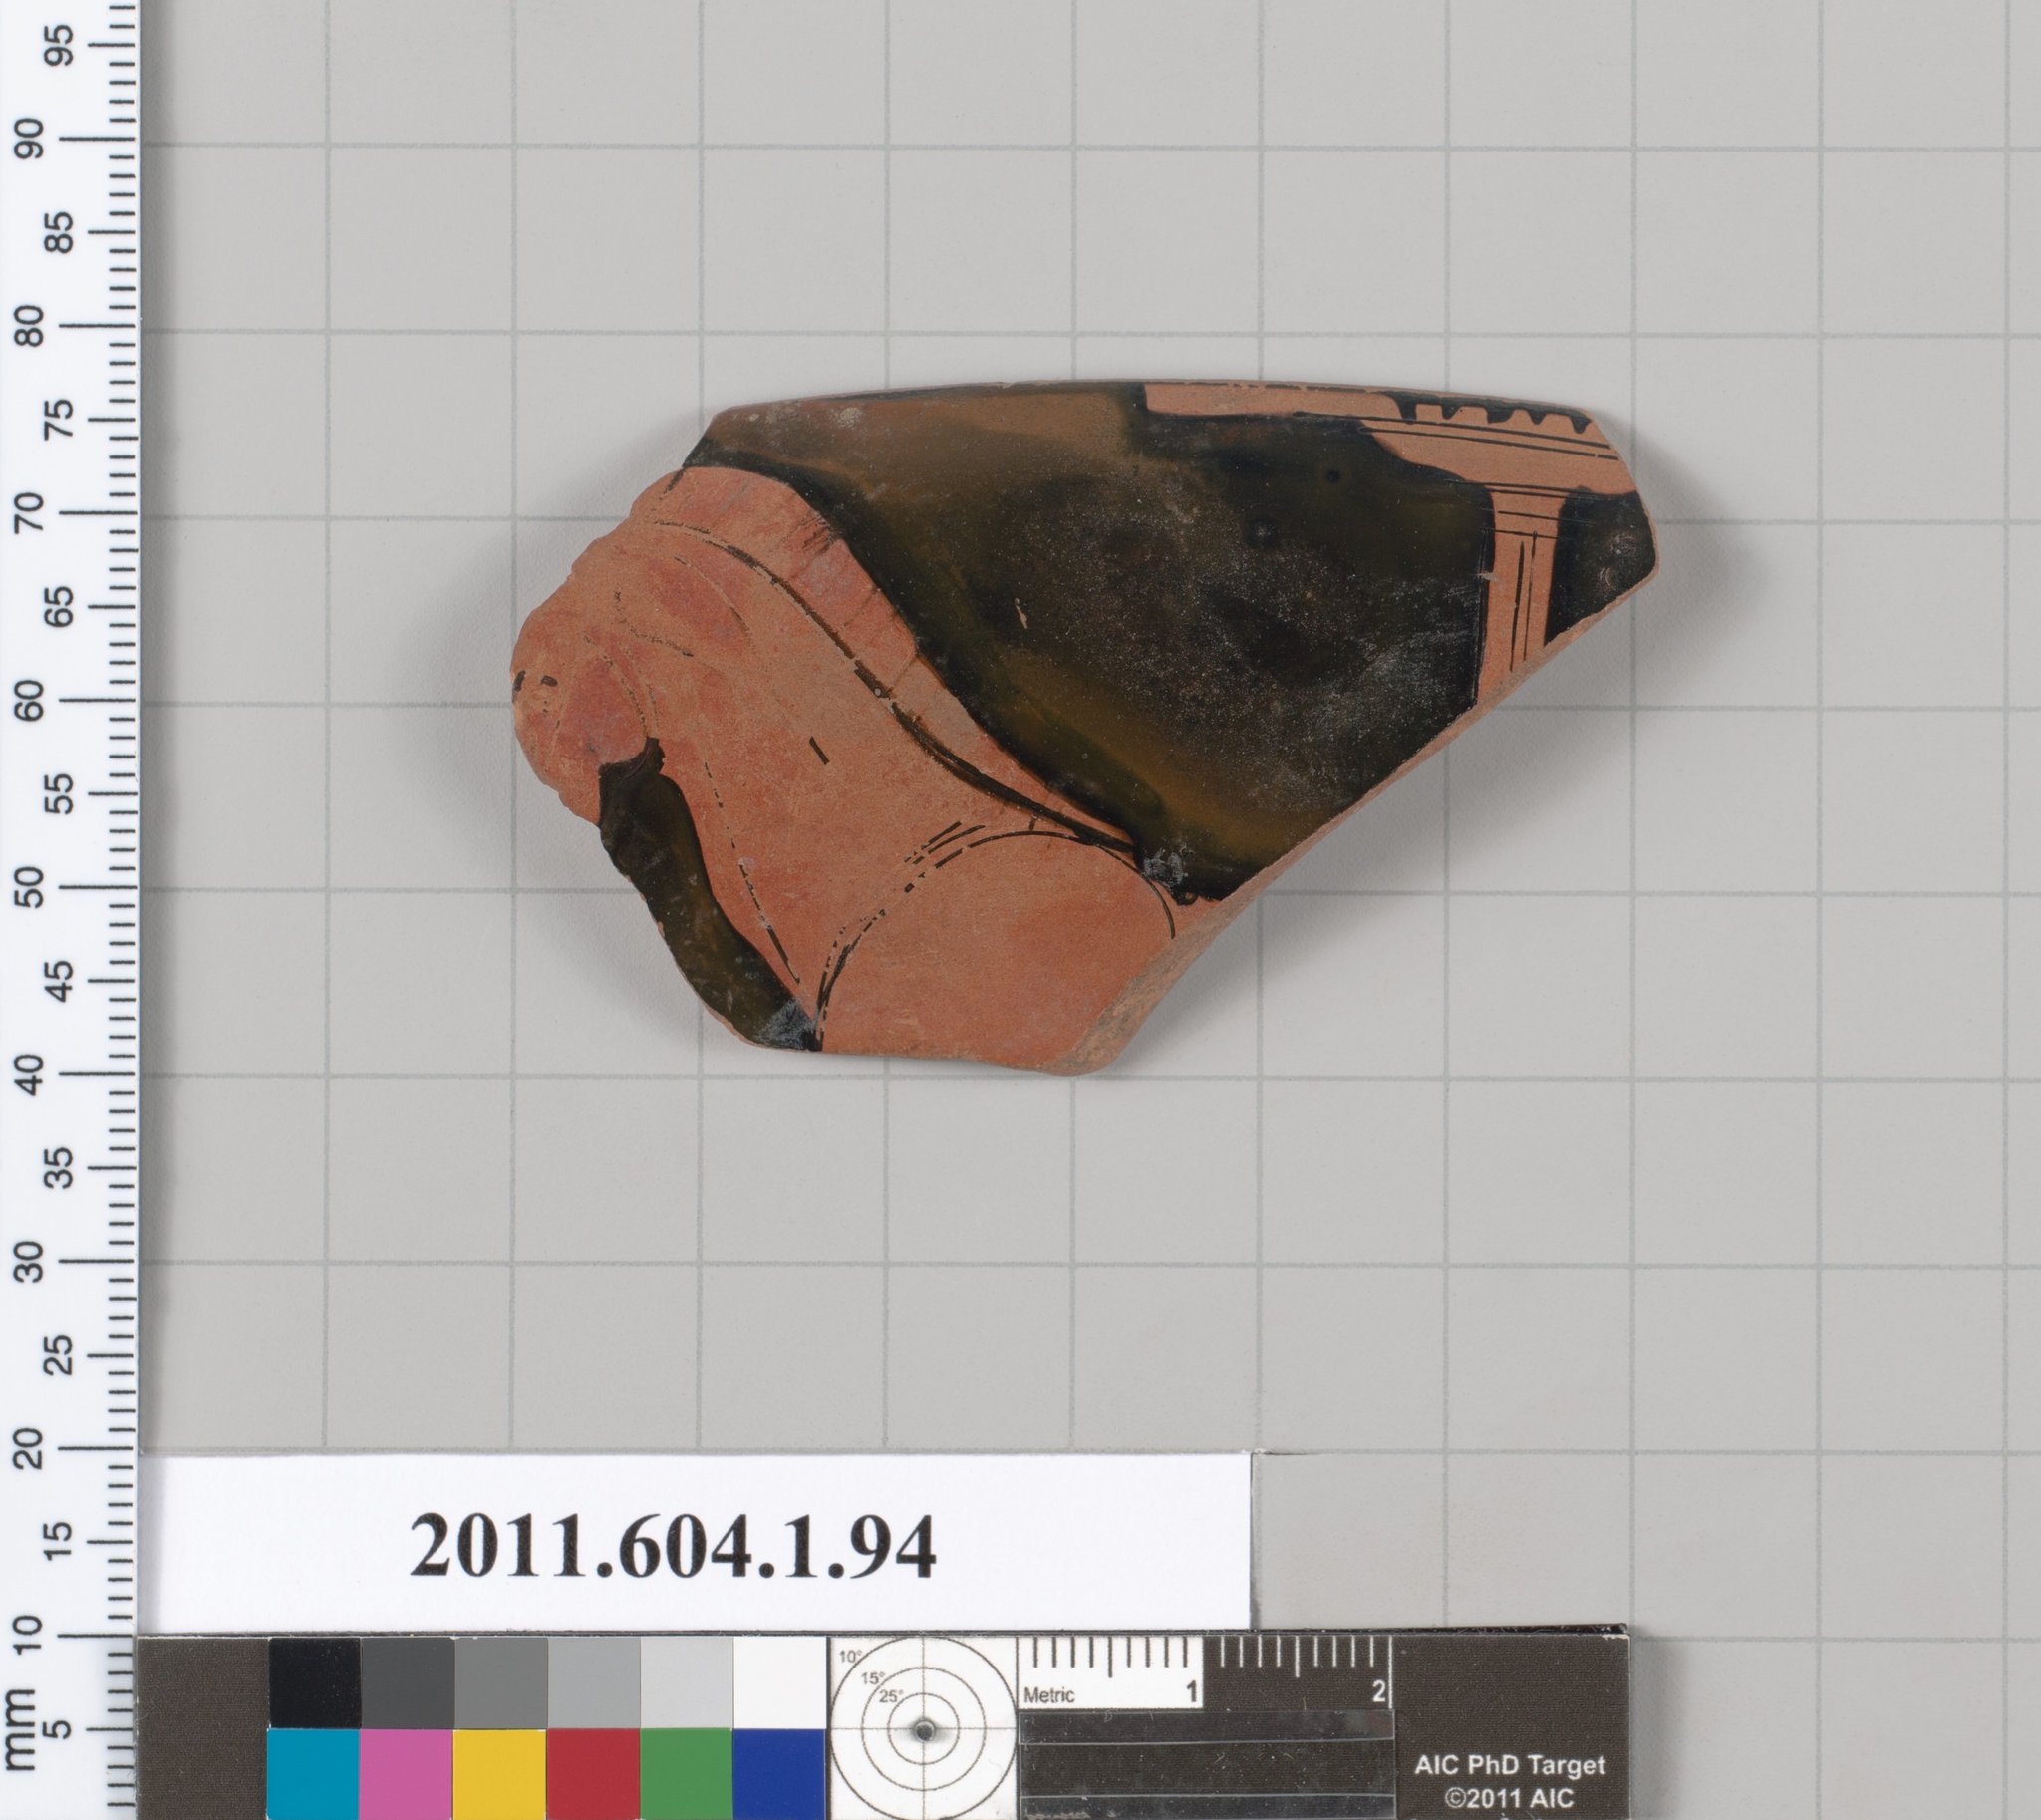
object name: kylix fragment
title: Terracotta rim fragment of a kylix (drinking cup)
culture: greek, attic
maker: painter of london d 12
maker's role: artist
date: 475-451 BCE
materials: terracotta